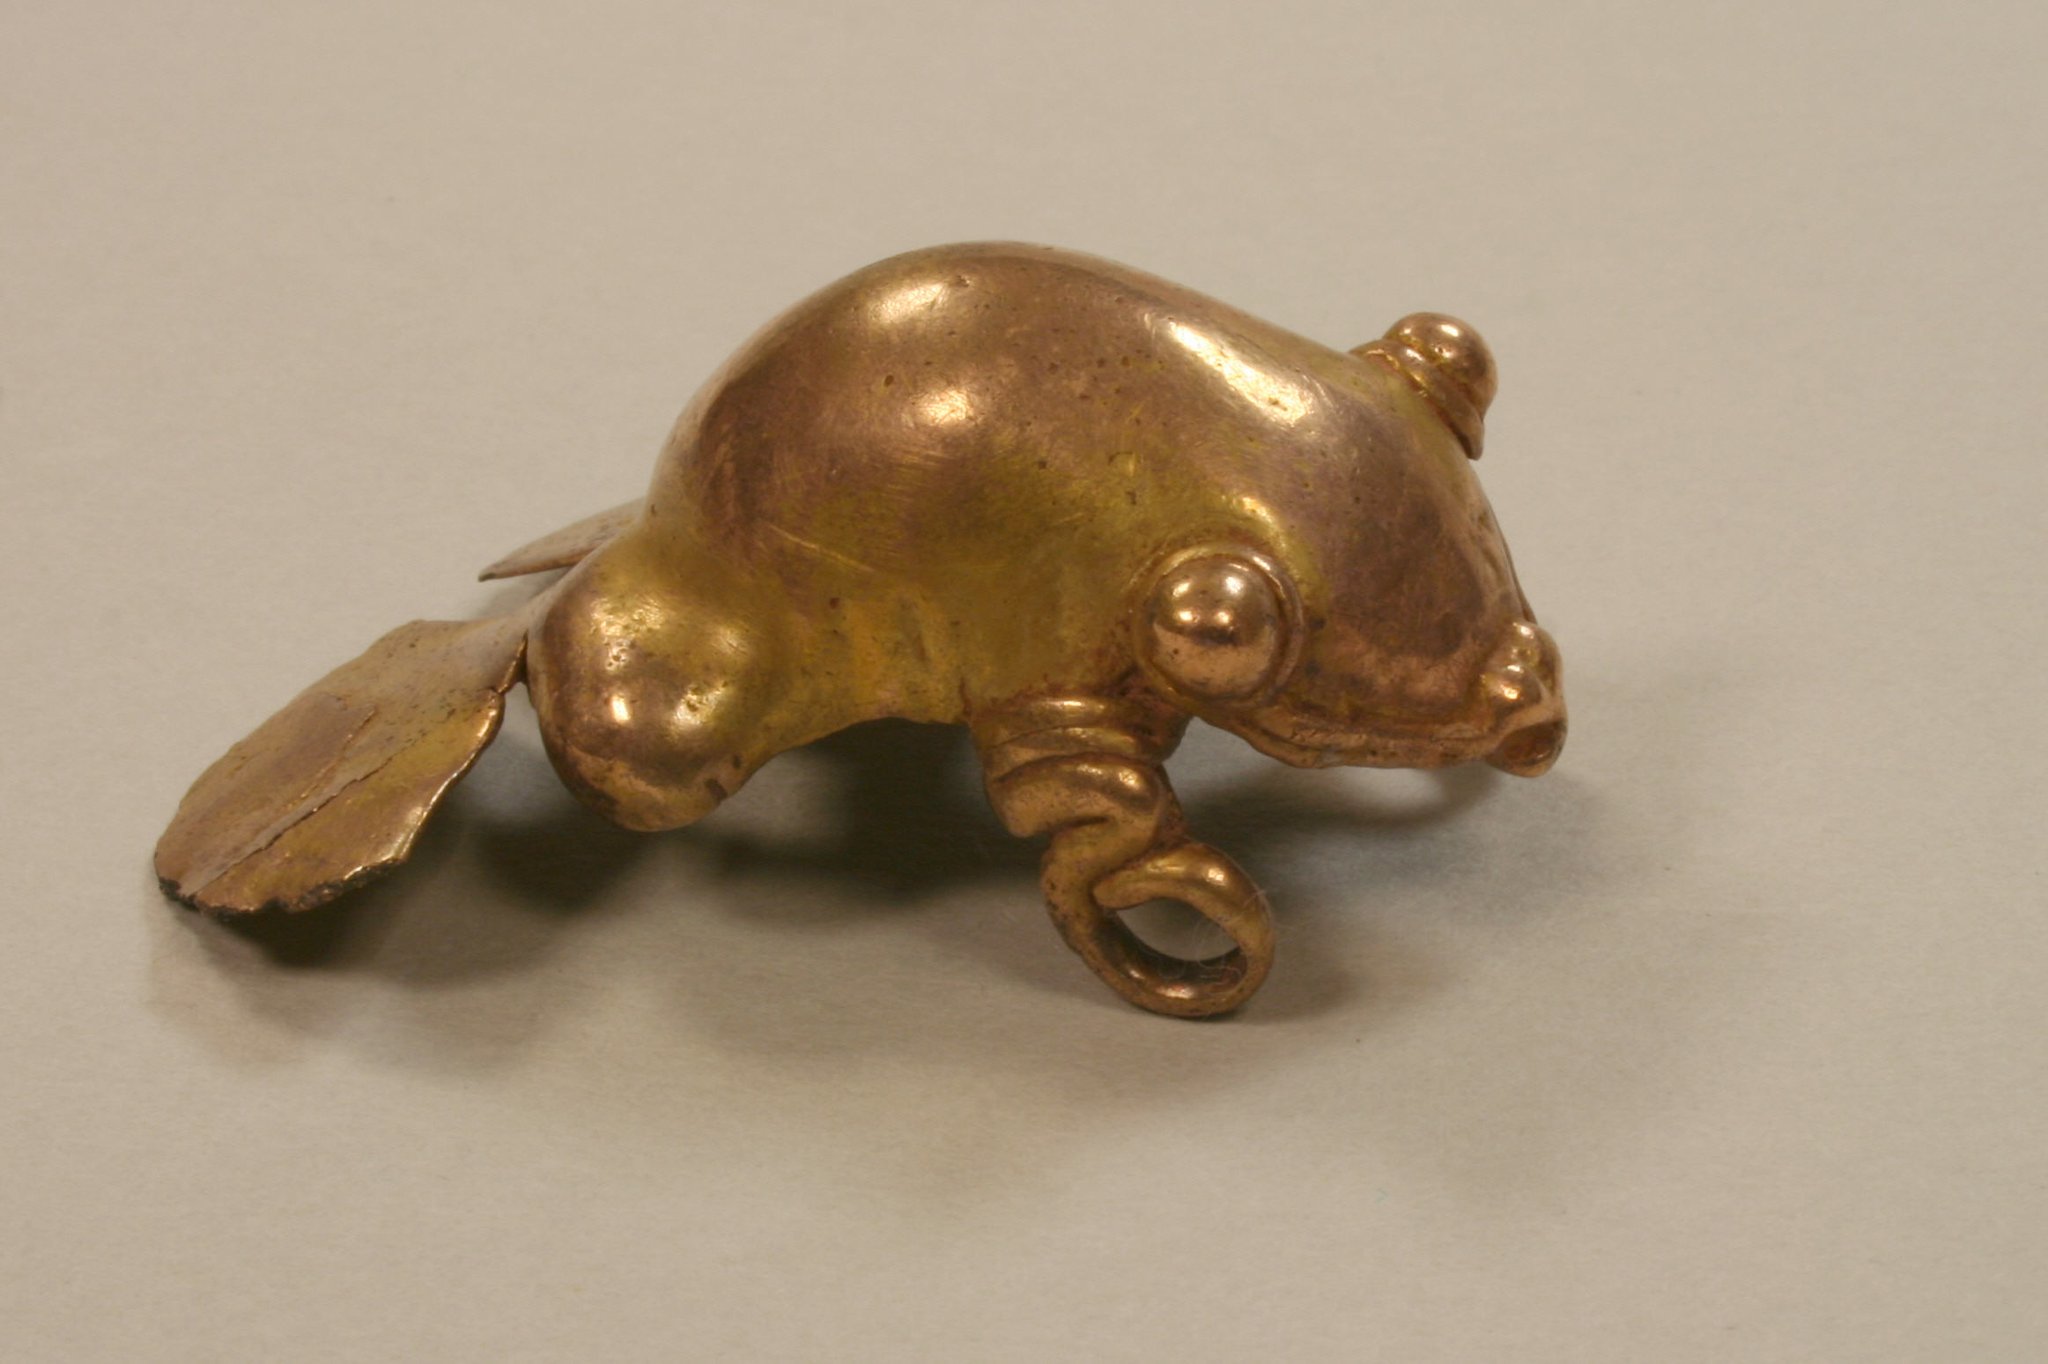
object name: pendant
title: Frog Pendant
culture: veraguas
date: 1001-1600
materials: gold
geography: panama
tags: frogs